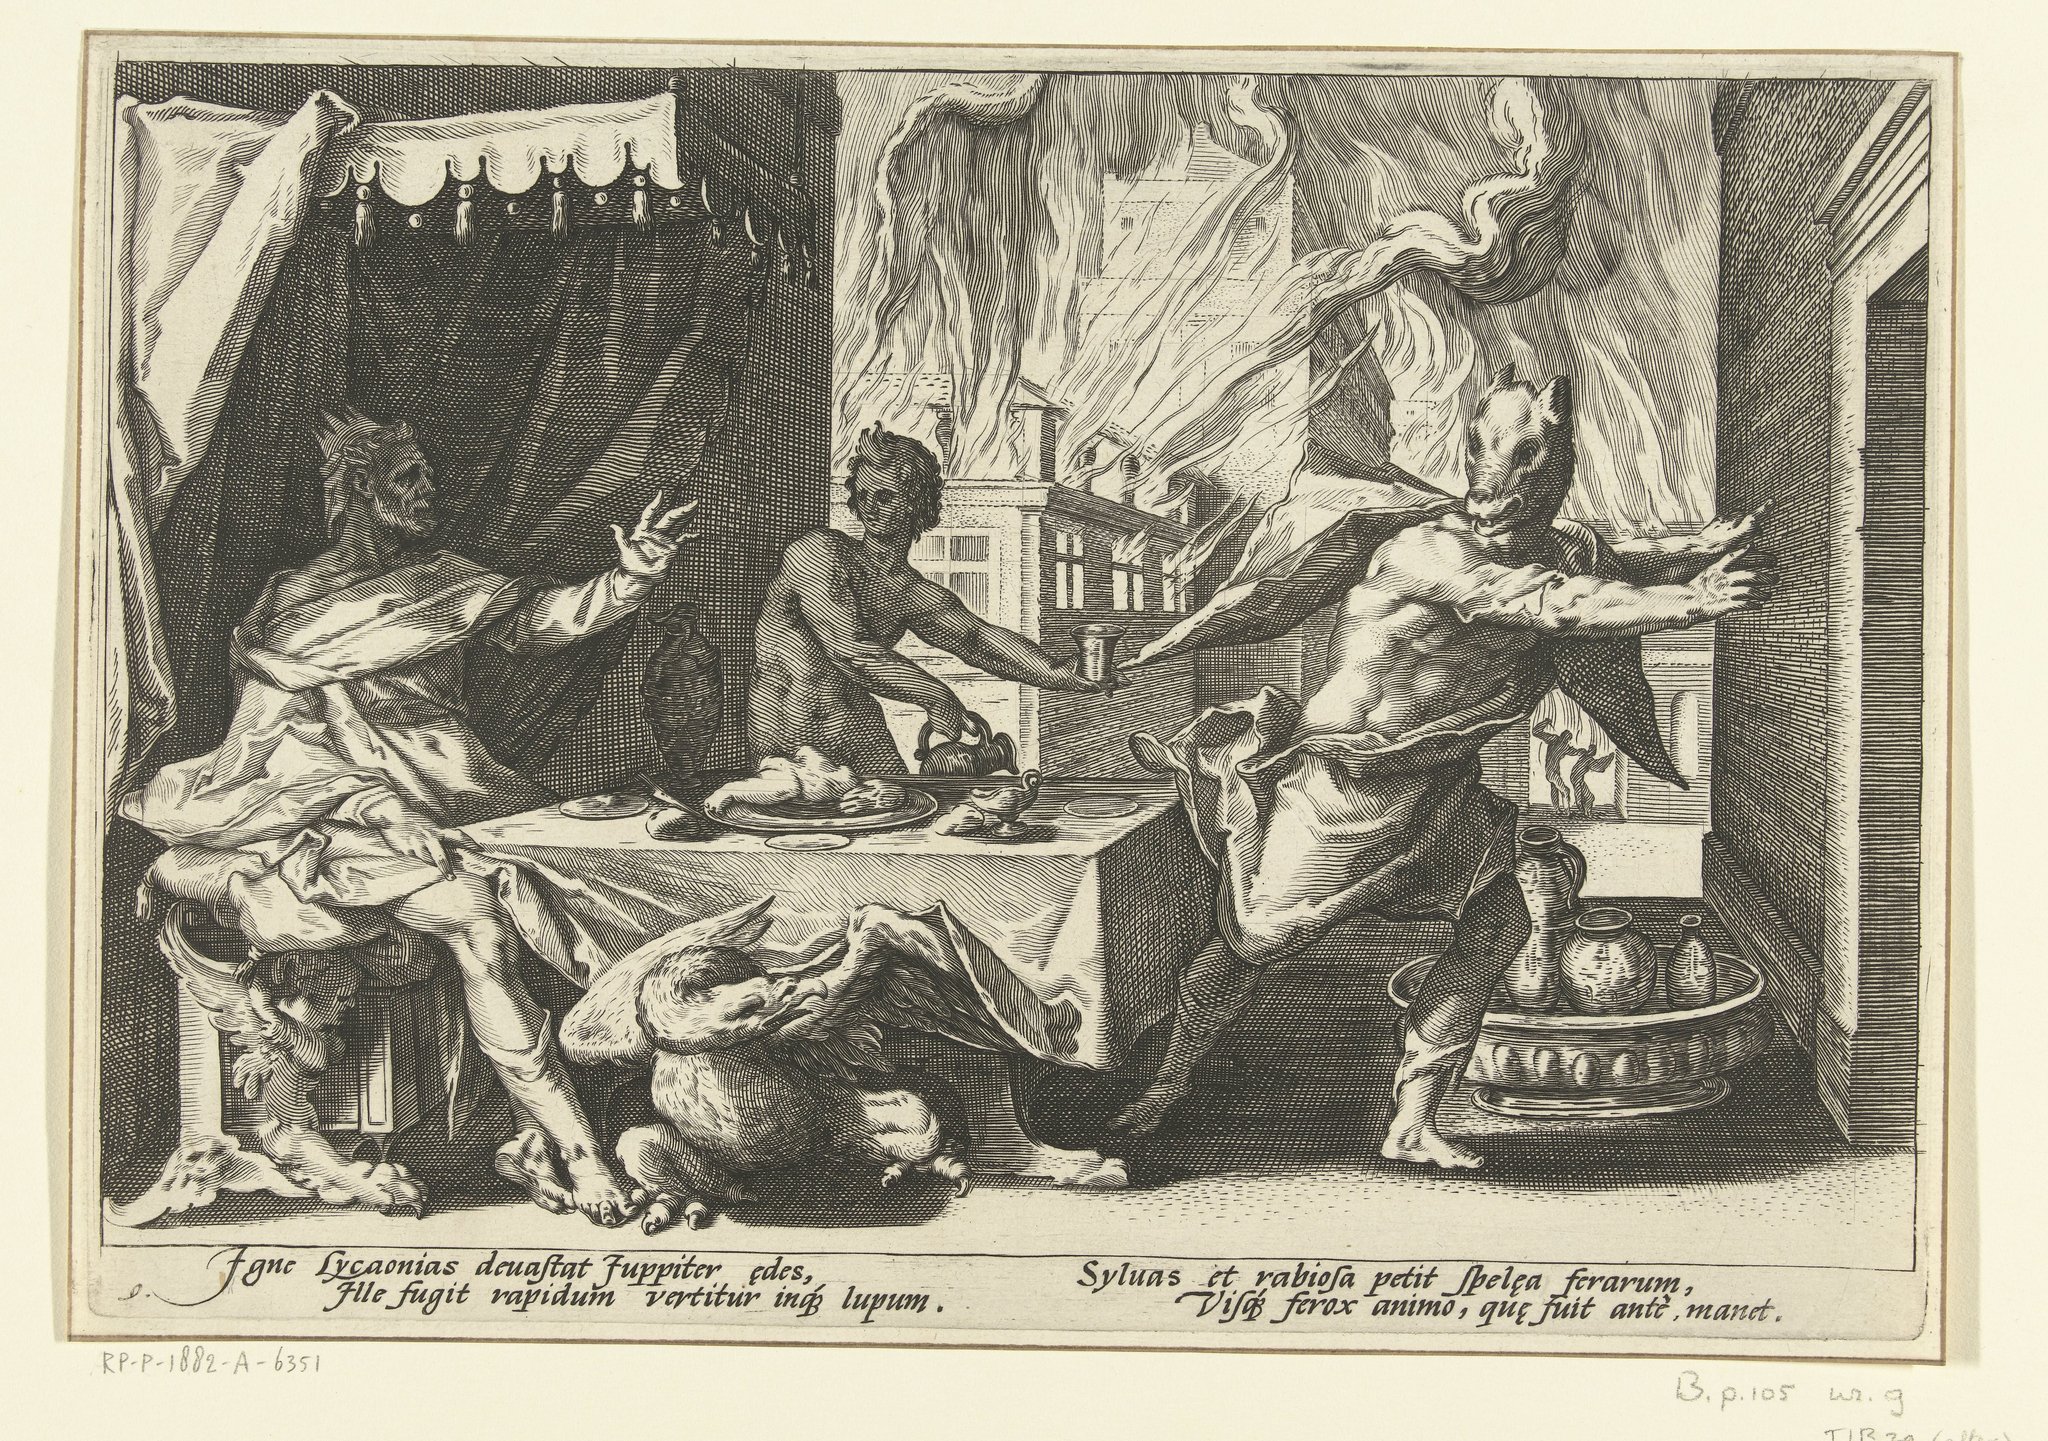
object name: print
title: Lycaon verandert in een wolf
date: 1589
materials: paper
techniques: engraving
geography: haarlem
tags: lycaon changed into a wolf: jupiter changes lycaon into a wolf as punishment for offering the god, who is sitting at table, human flesh to eat; lycaon's house is struck with lightning (ovid, metamorphoses i 237)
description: Jupiter zit aan tafel, de adelaar aan zijn voeten. Lycaon vlucht van hem weg, zijn hoofd reeds veranderd in een wolvenkop. Met deze metamorfose van mens naar wolf strafte Jupiter Lycaon voor het opdienen mensenvlees. Op de achtergrond gaat Lycaons huis in vlammen op - een tweede straf voor het vleesmaal. Onder de voorstelling twee keer twee regels Latijnse tekst. Deze prent is onderdeel van een serie van 52 prenten die verhalen uit Ovidius' Metamorfosen verbeelden. Deze serie valt uiteen in drie genummerde reeksen: twee van 20 prenten en één van 12 prenten. Deze prent behoort tot de eerste reeks.